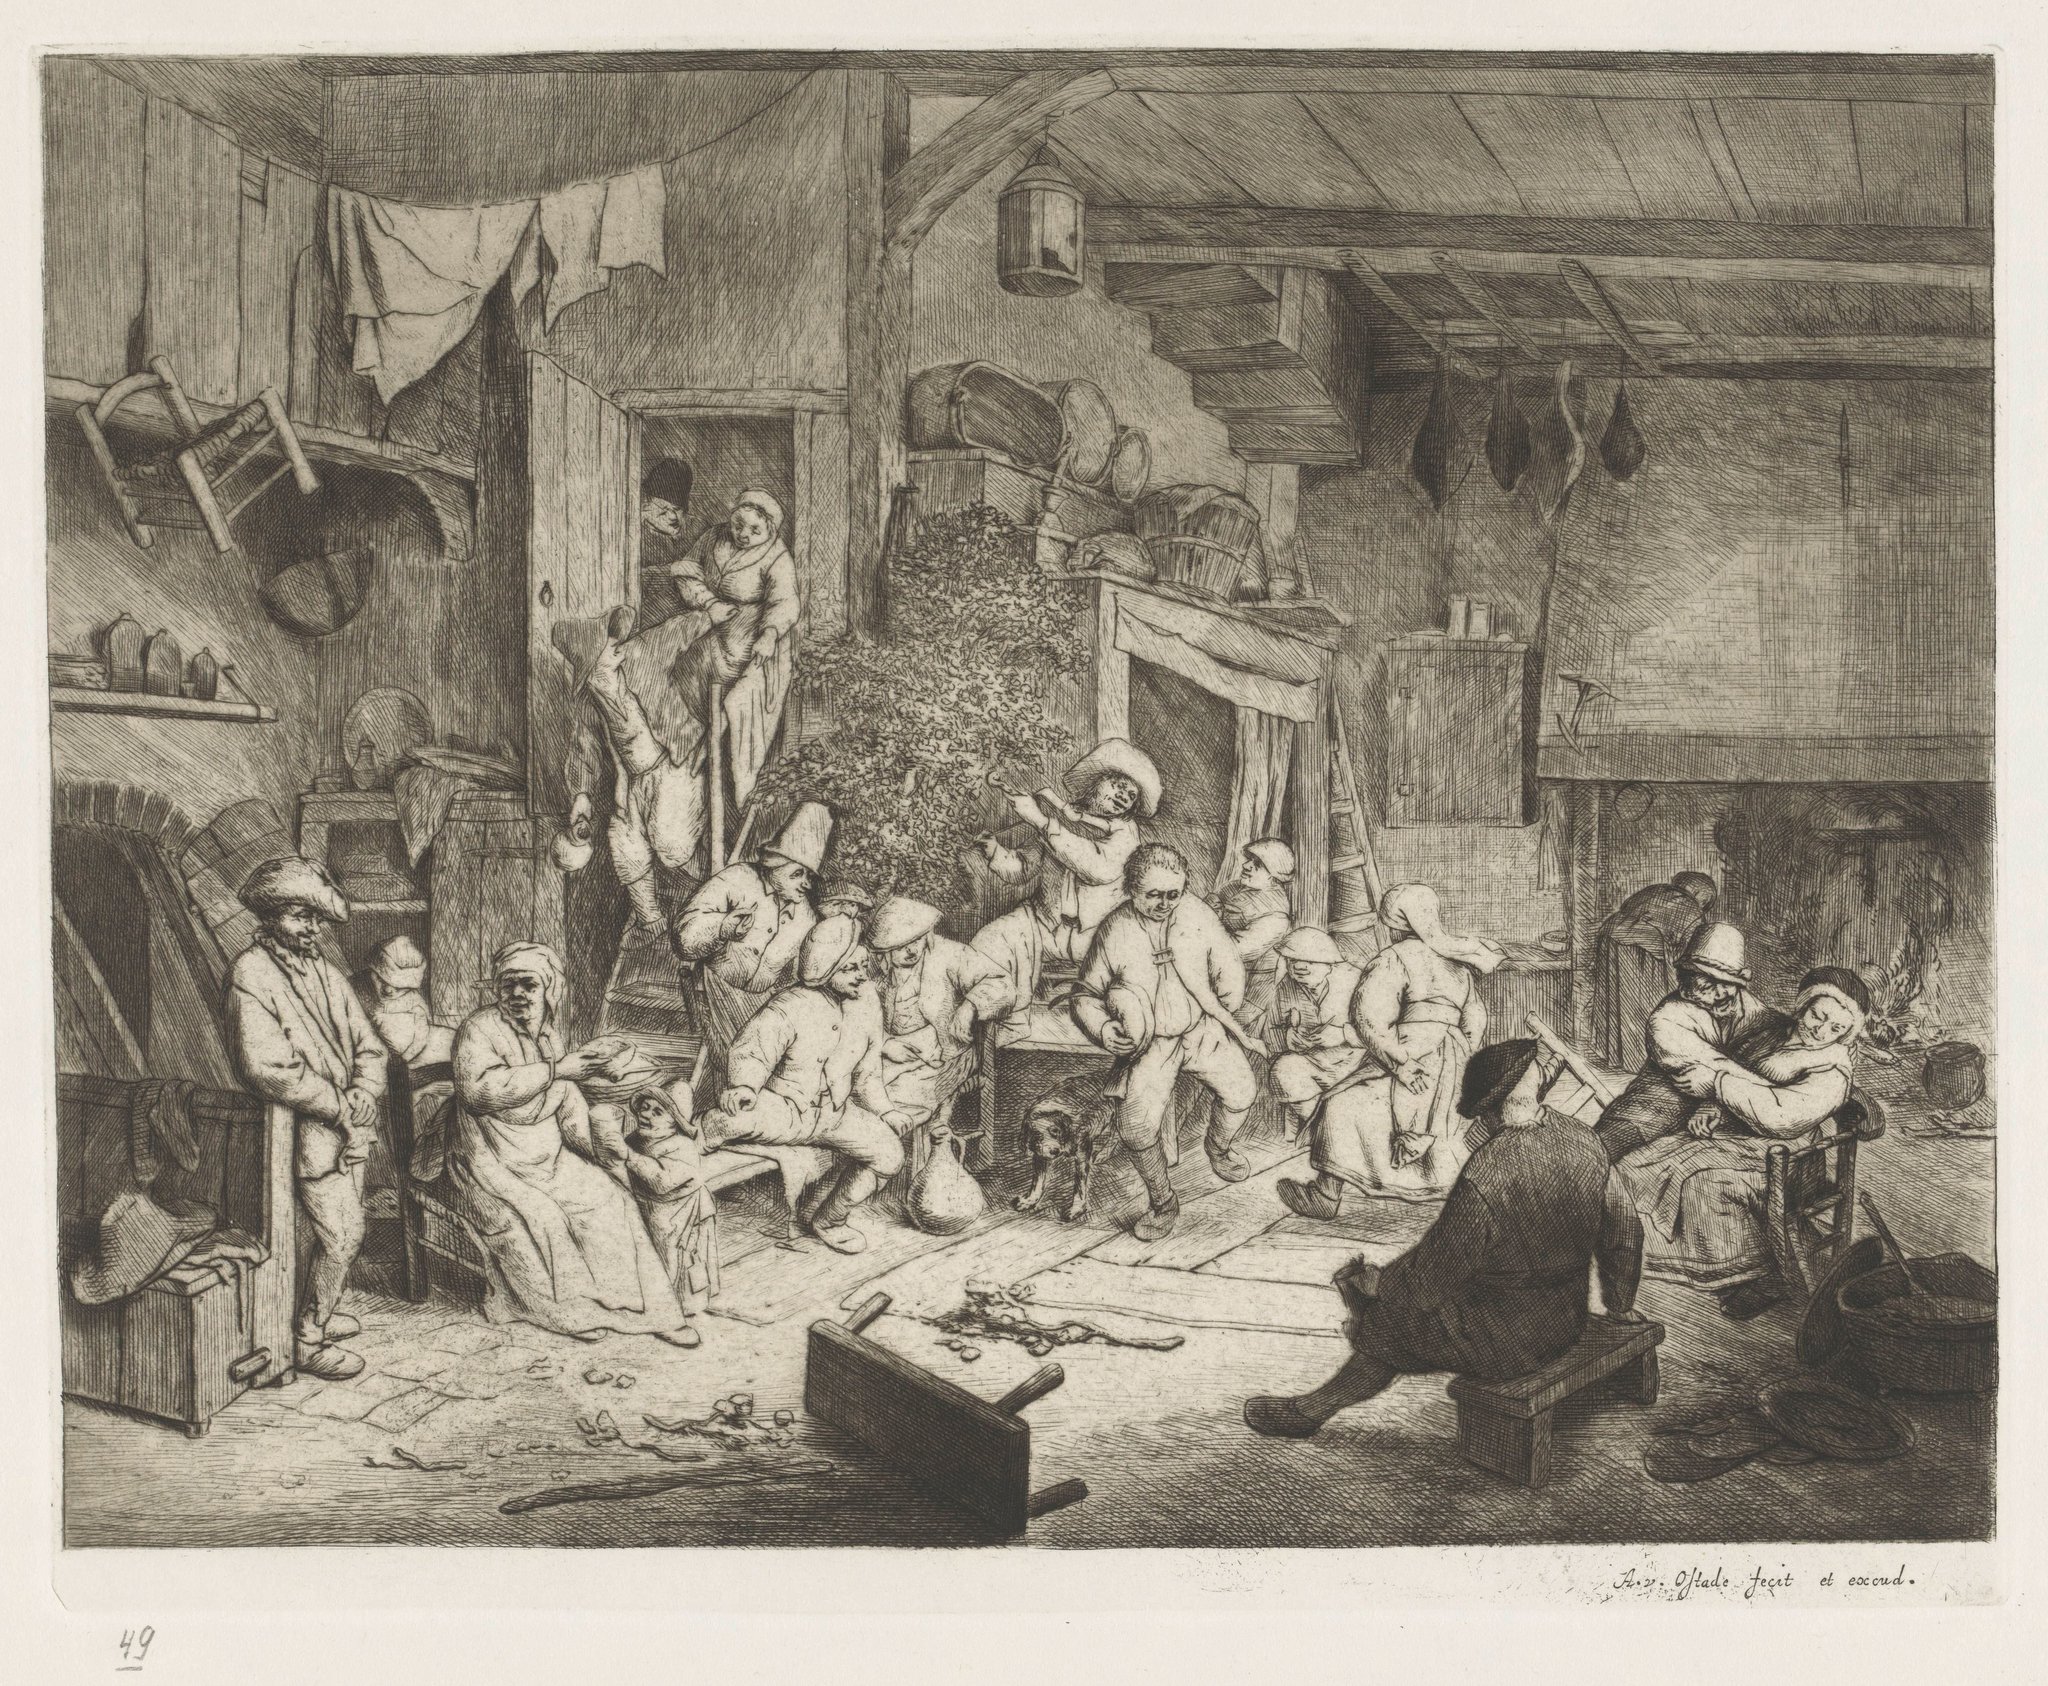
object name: print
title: Dans in de herberg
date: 1650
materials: paper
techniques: etching, galvanization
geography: haarlem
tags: inn, coffee-house, public house, etc., one pair dancing; man and woman dancing as a couple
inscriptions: collector's mark: ‘B’, collector's mark: ‘RIJKS / MUSM’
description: Een groep mensen in een rommelige herberg, te midden van hen dansen een man en een vrouw op de muziek van een vedelspeler. Geheel links omhelst een man een zittende vrouw. Drie personen komen de herberg binnen via een trap. De prent maakt deel uit van een portefeuille.